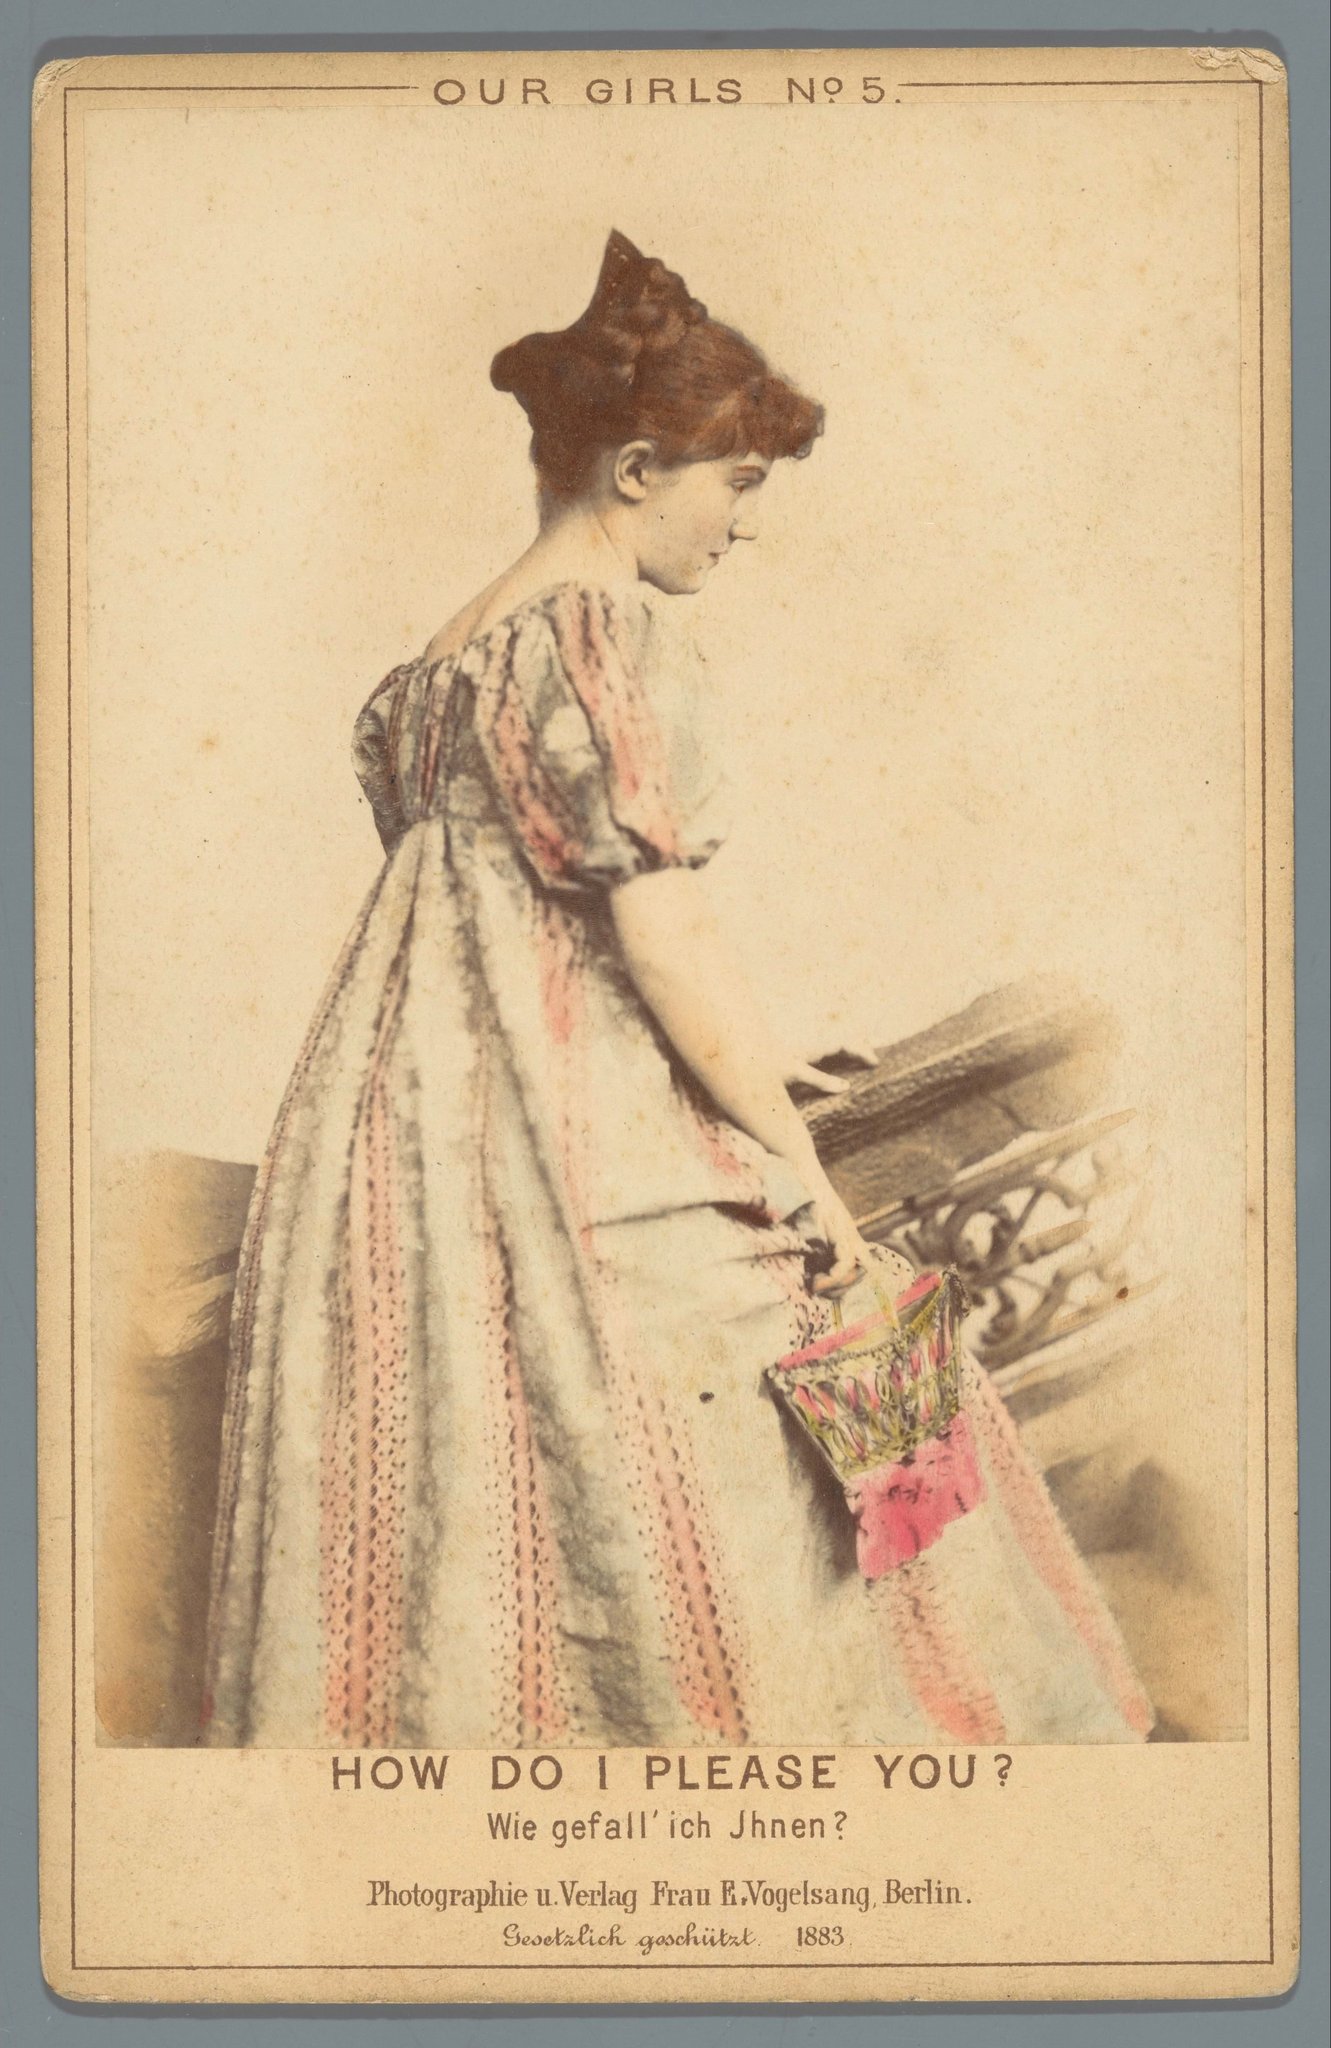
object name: cabinet photograph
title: How do I please you?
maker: e. vogelsang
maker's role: fotograaf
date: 1883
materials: cardboard, photographic support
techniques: albumen print, hand coloring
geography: berlin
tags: girl (child between toddler and youth)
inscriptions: inscription: ‘Our girls no. 5’